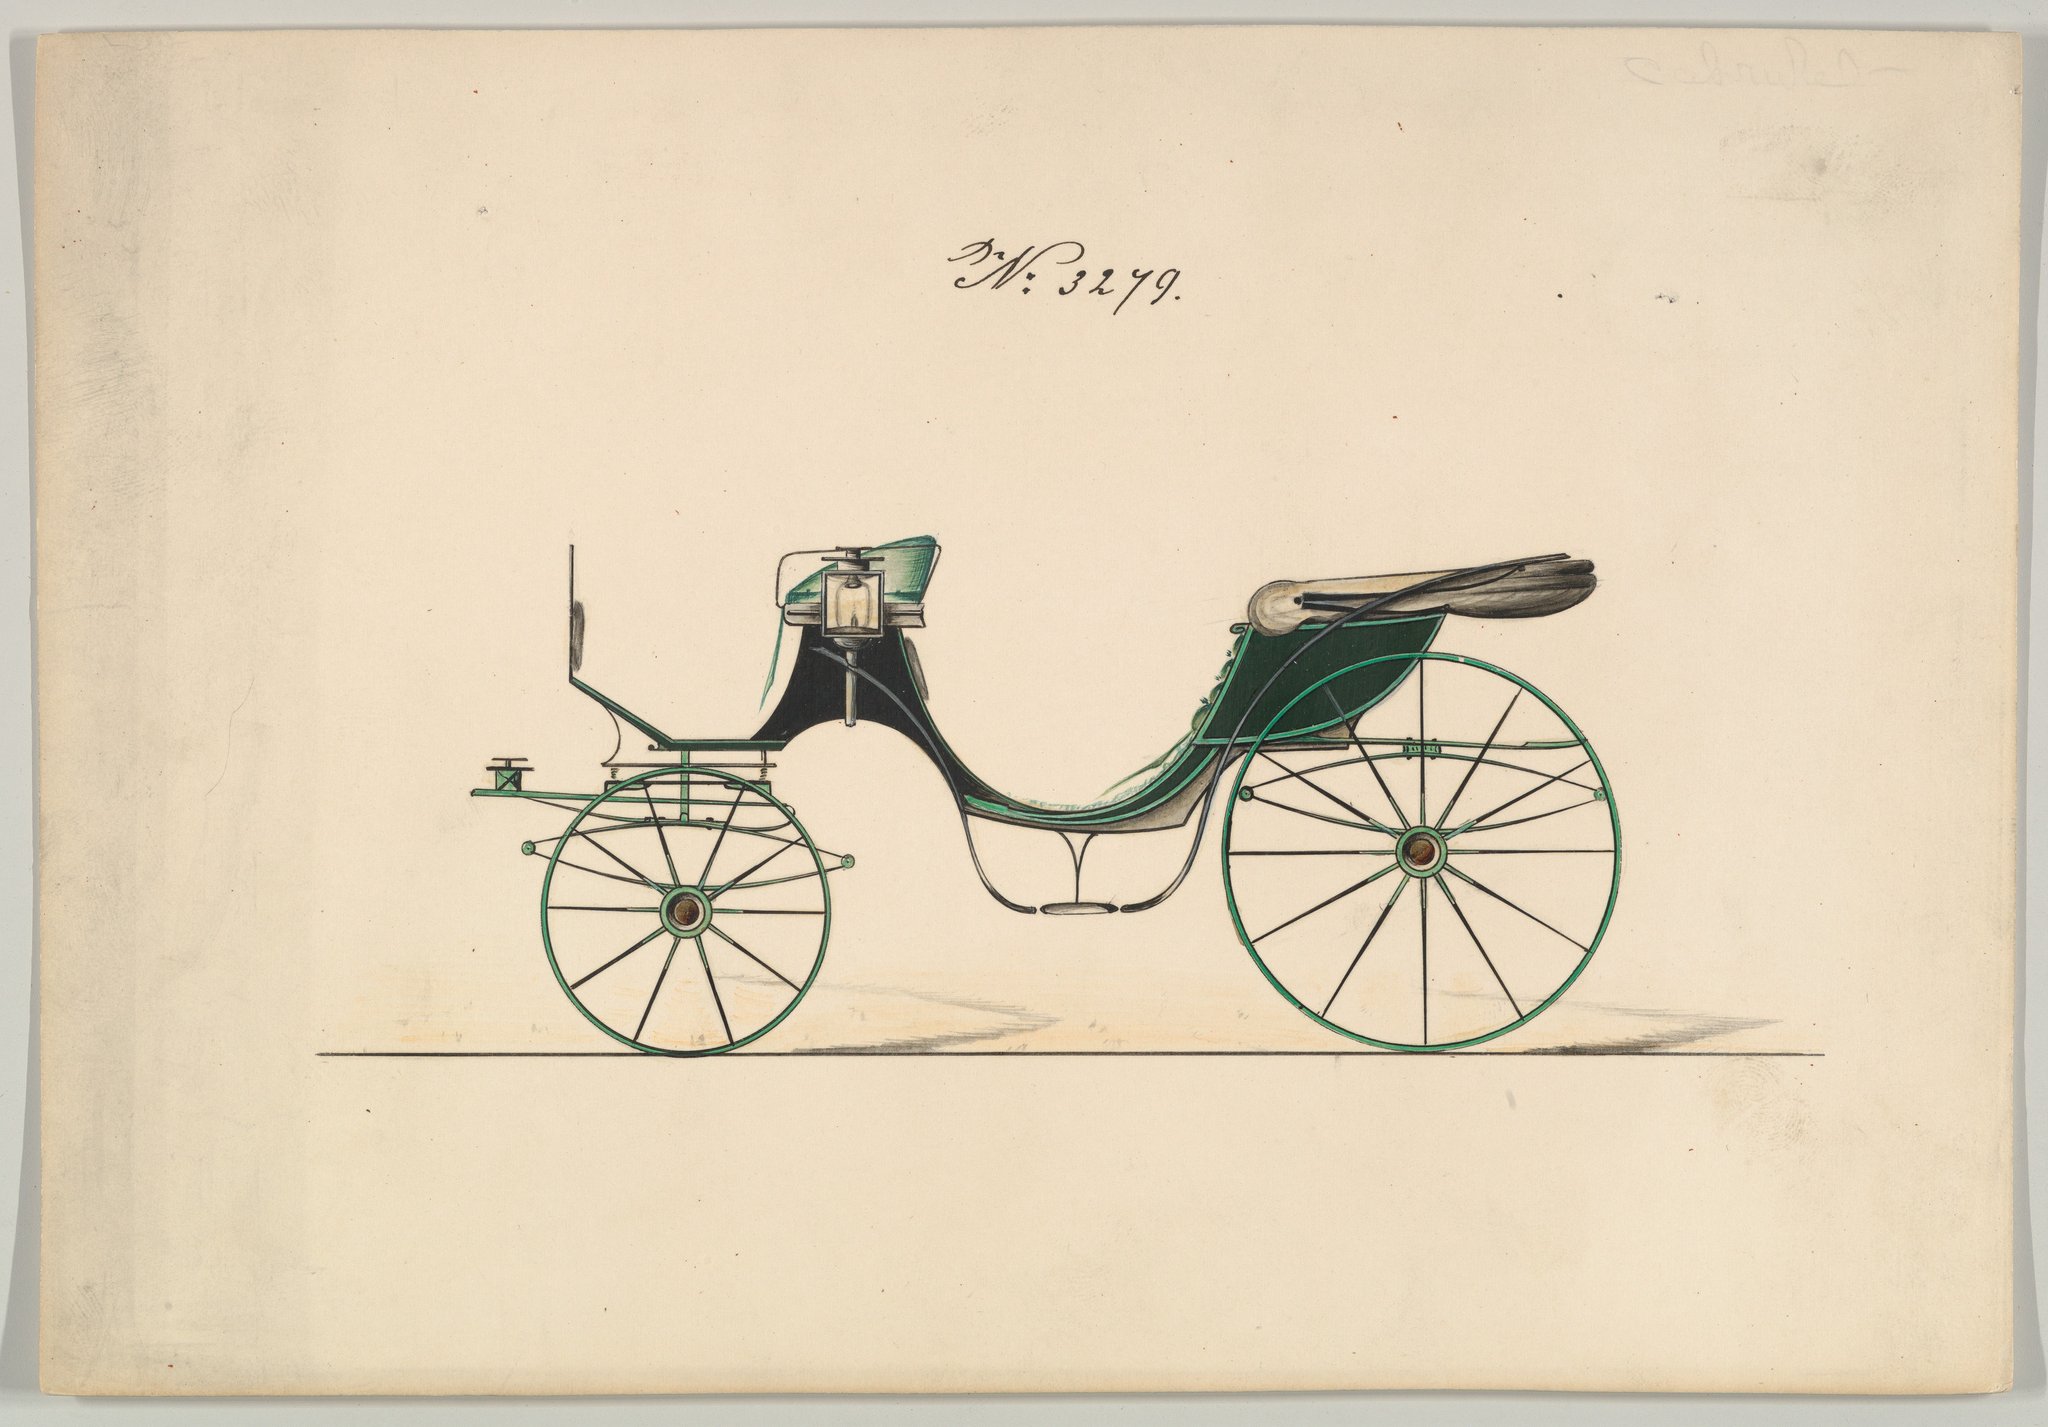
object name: drawing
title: Cabriolet #3279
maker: brewster & co.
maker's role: manufacturer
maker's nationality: american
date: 1876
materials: ink, watercolor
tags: carriages